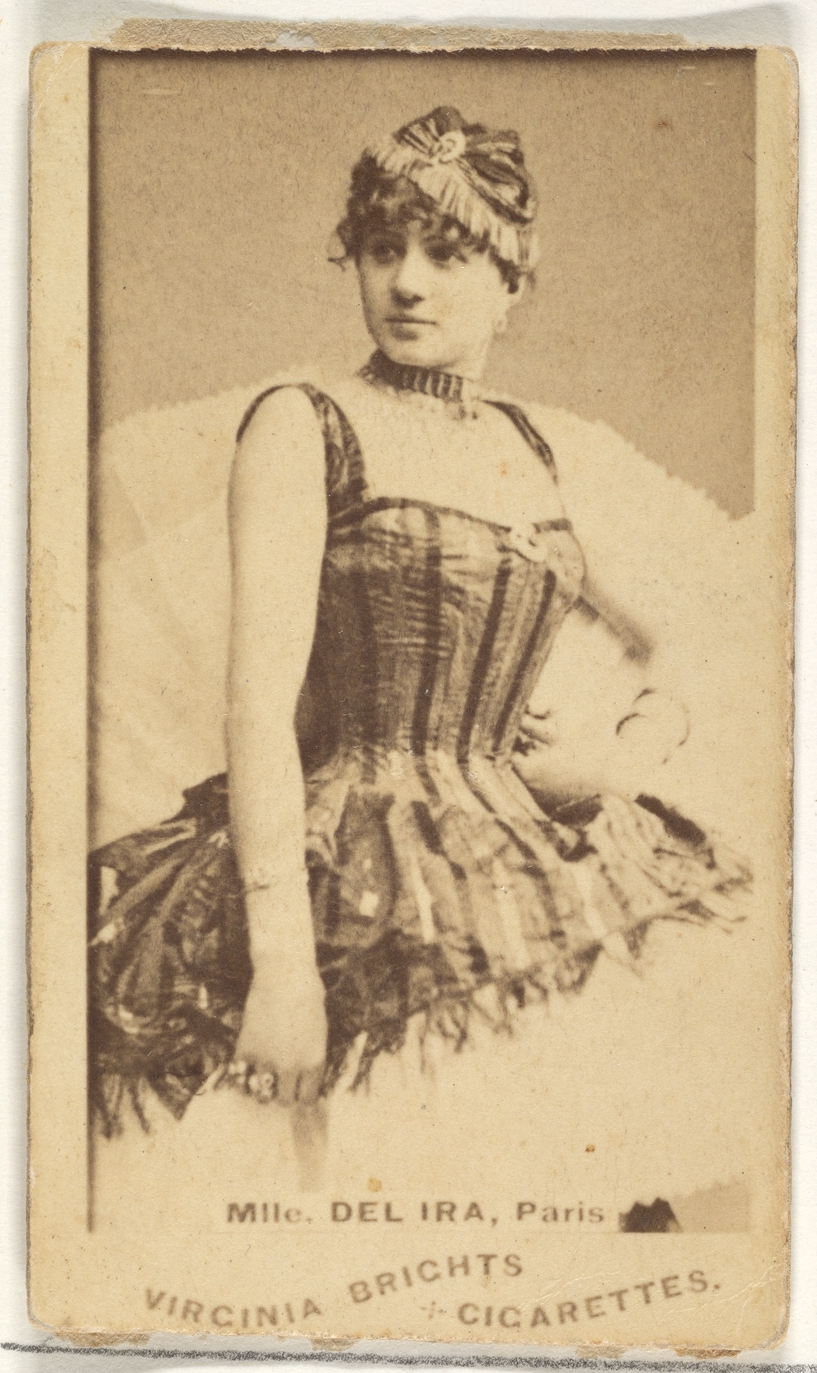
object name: photograph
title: Mlle. Del Ira, Paris, from the Actors and Actresses series (N45, Type 1) for Virginia Brights Cigarettes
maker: allen & ginter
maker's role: publisher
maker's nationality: american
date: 1888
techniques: albumen silver print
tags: portraits,women,actresses